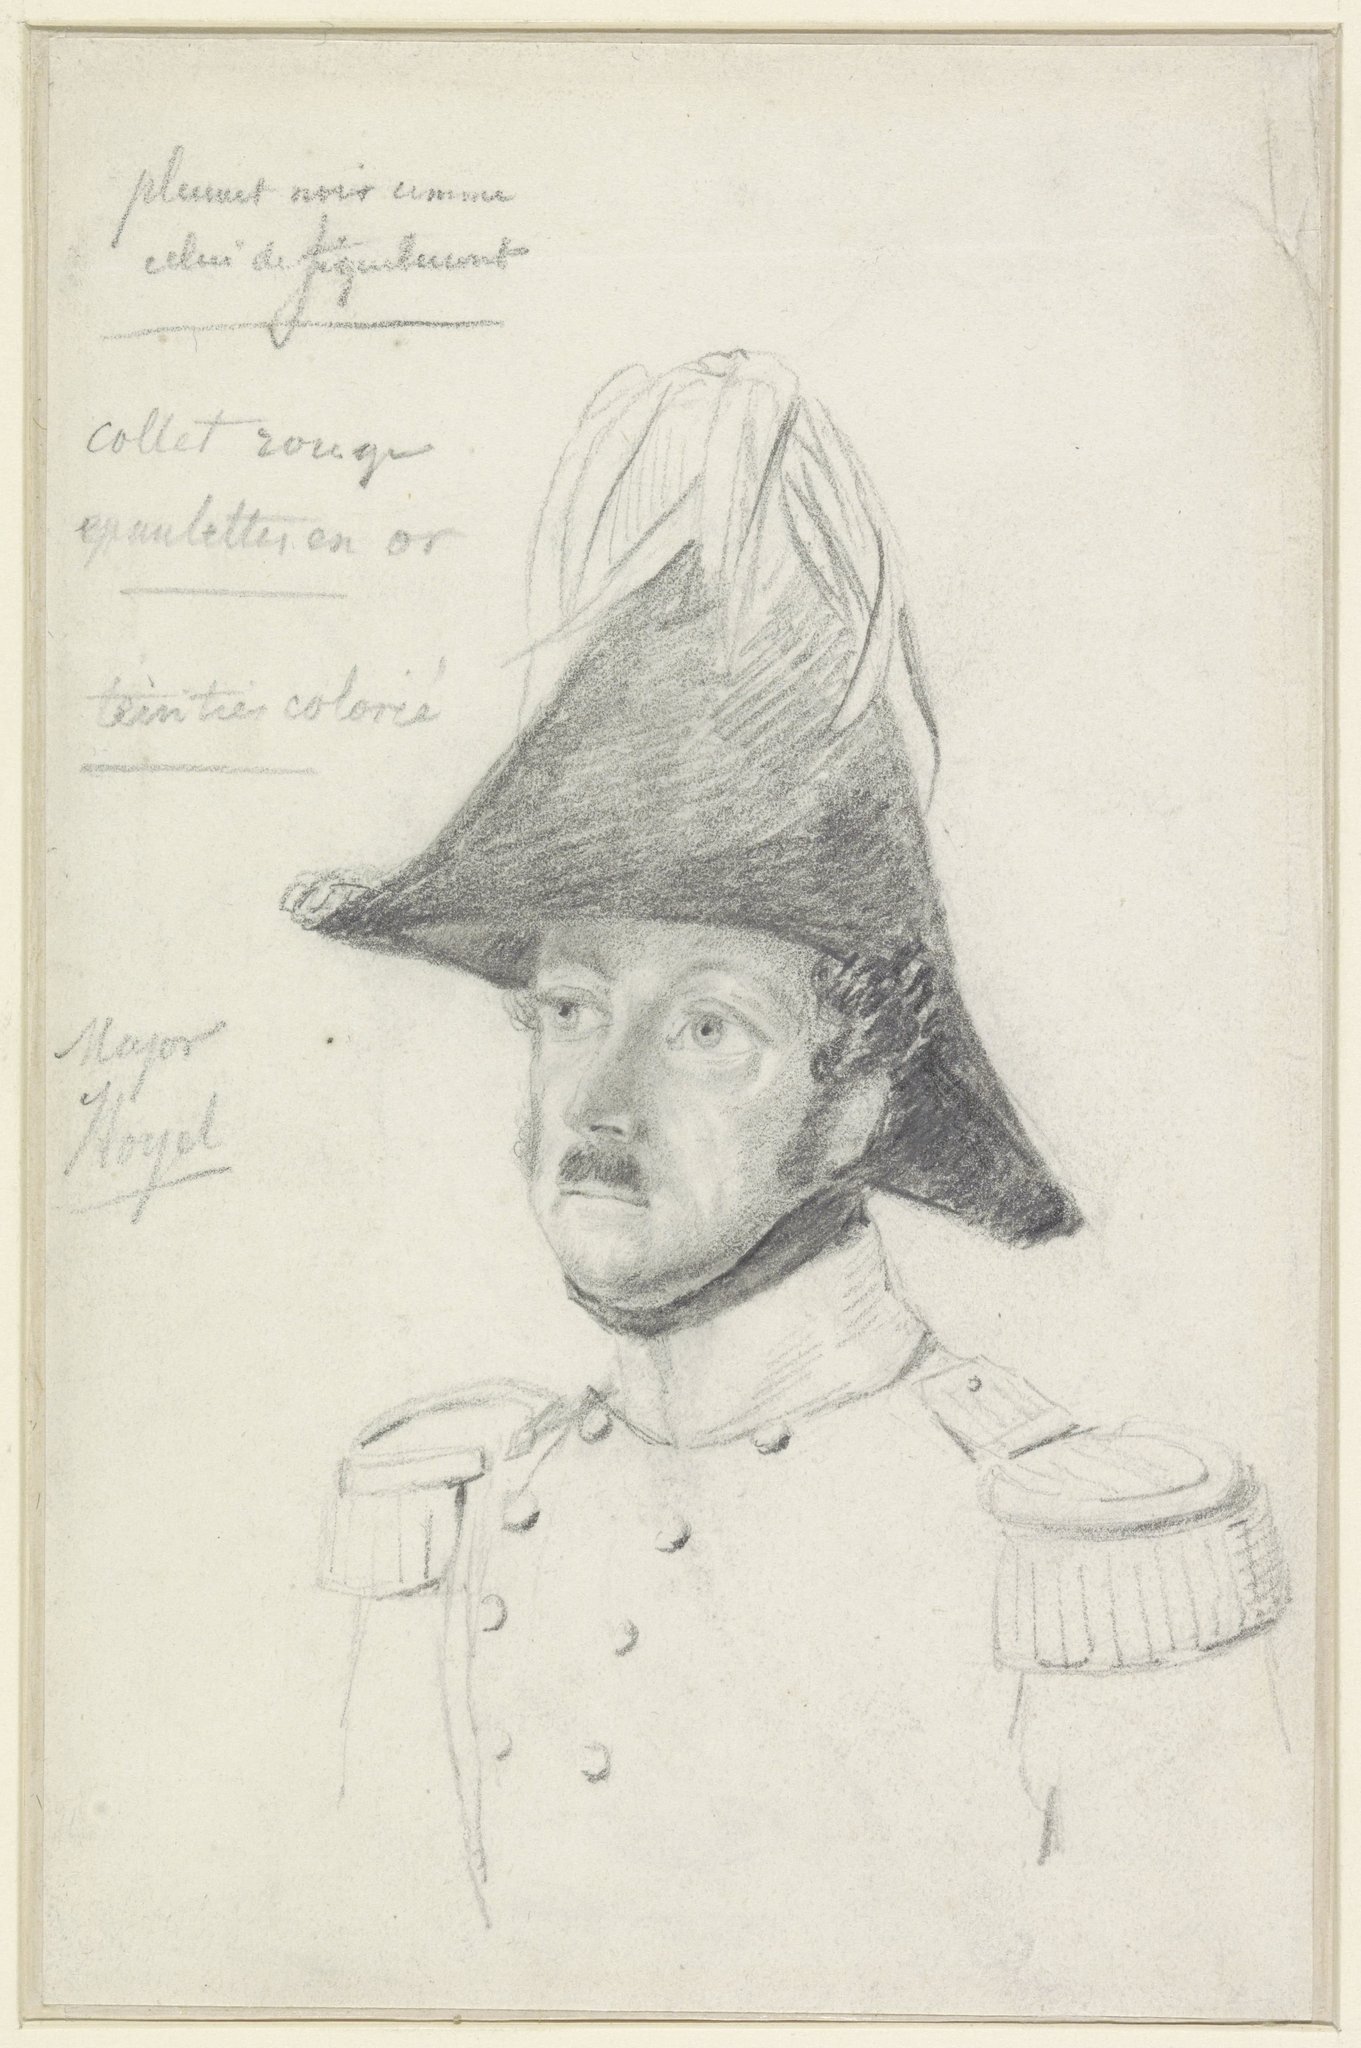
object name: drawing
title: Portret van Majoor Hoyel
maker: jacob joseph eeckhout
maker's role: draughtsman, print maker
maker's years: 1793-1861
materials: paper, pencil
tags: historical persons, officer (with name of rank)